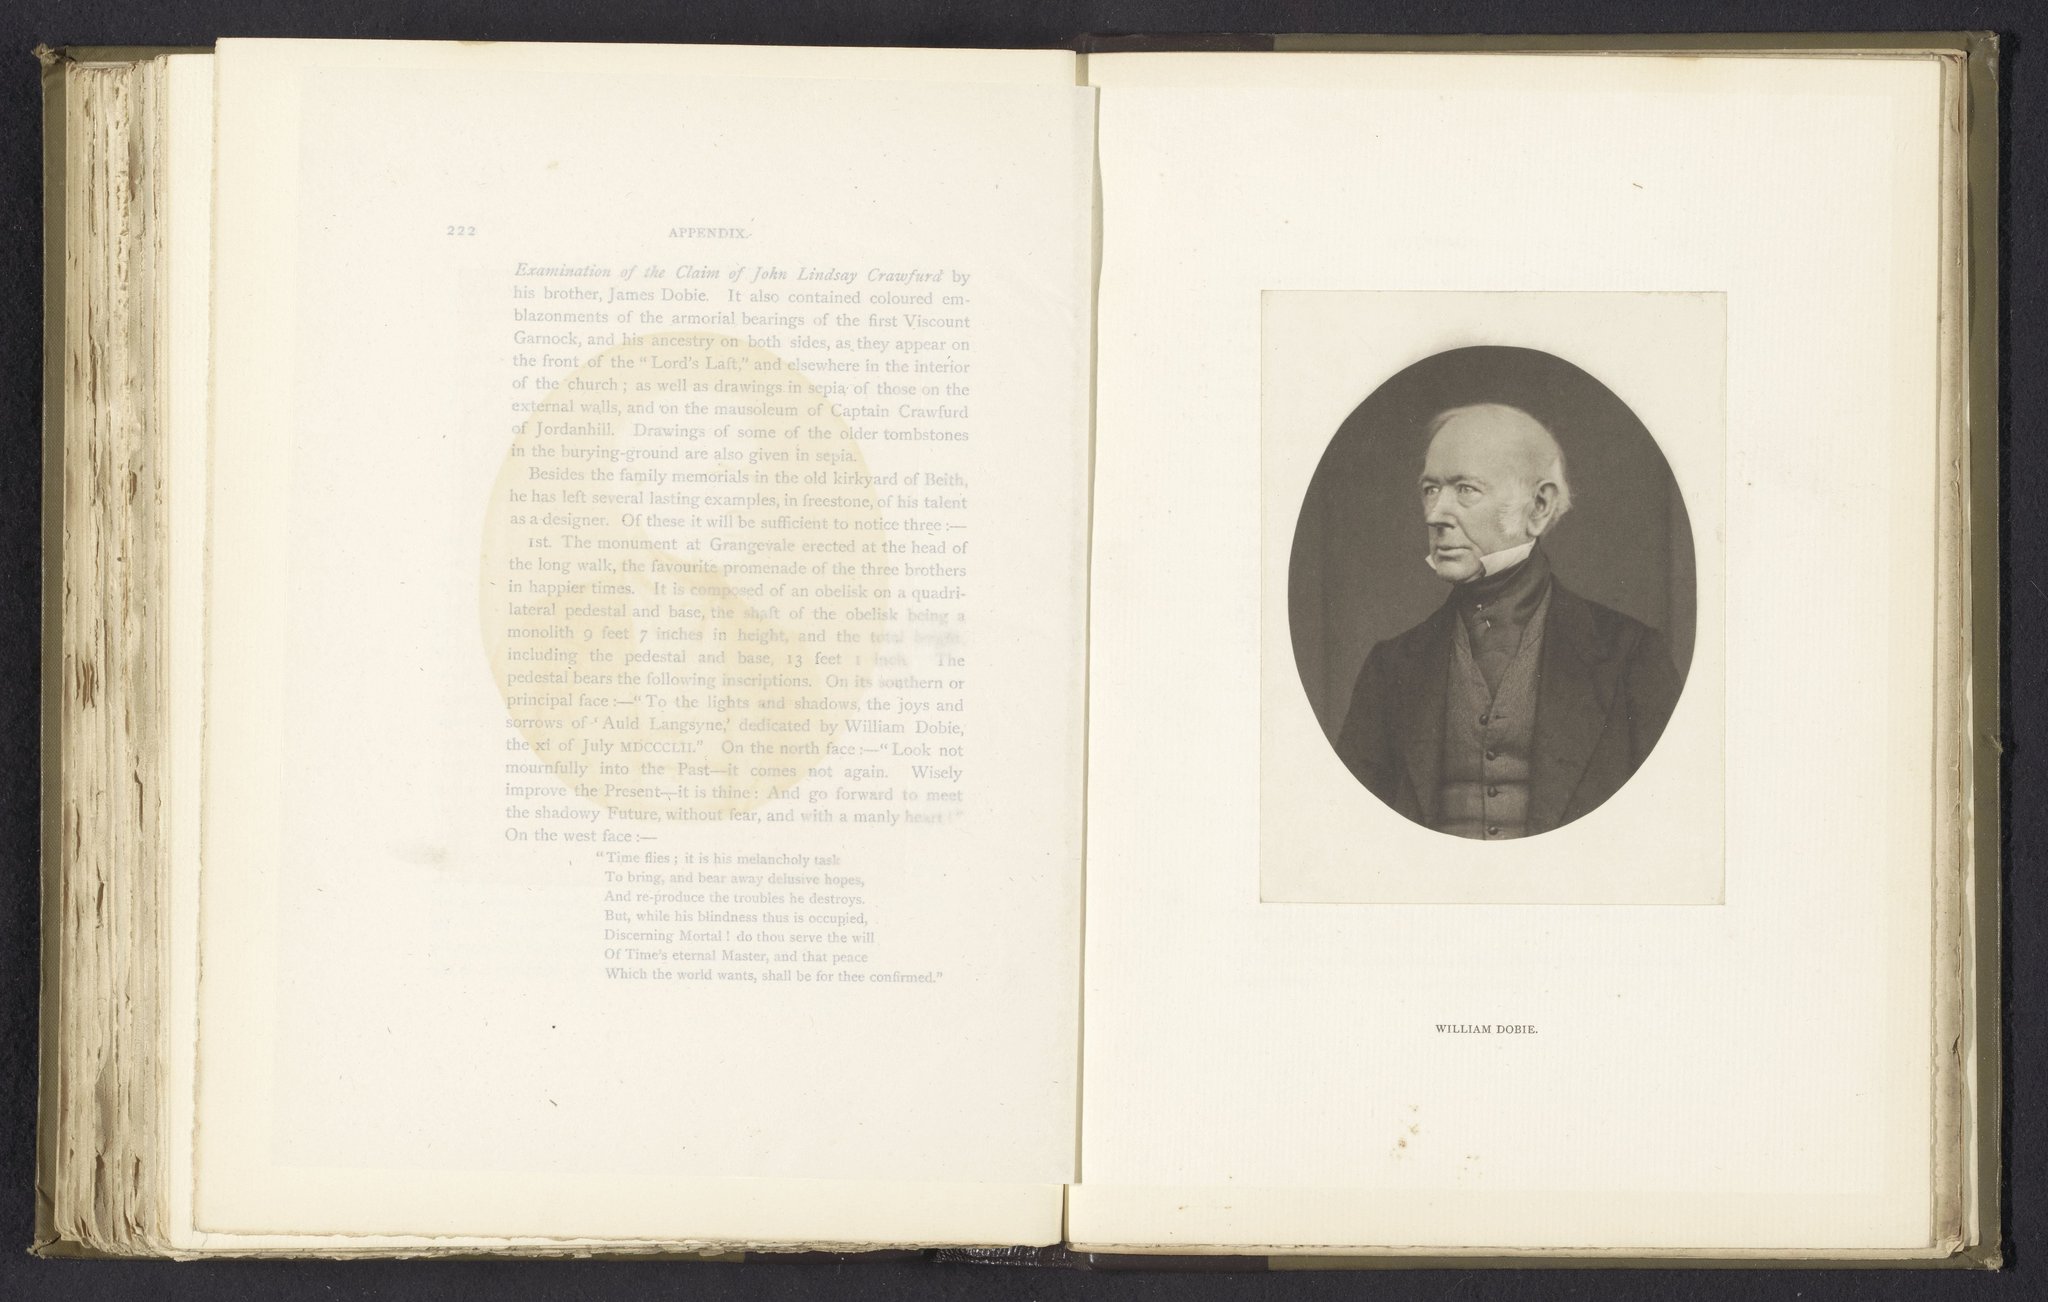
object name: photograph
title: William Dobie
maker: Anonymous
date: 1858-1868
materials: photographic support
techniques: platinum process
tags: historical persons